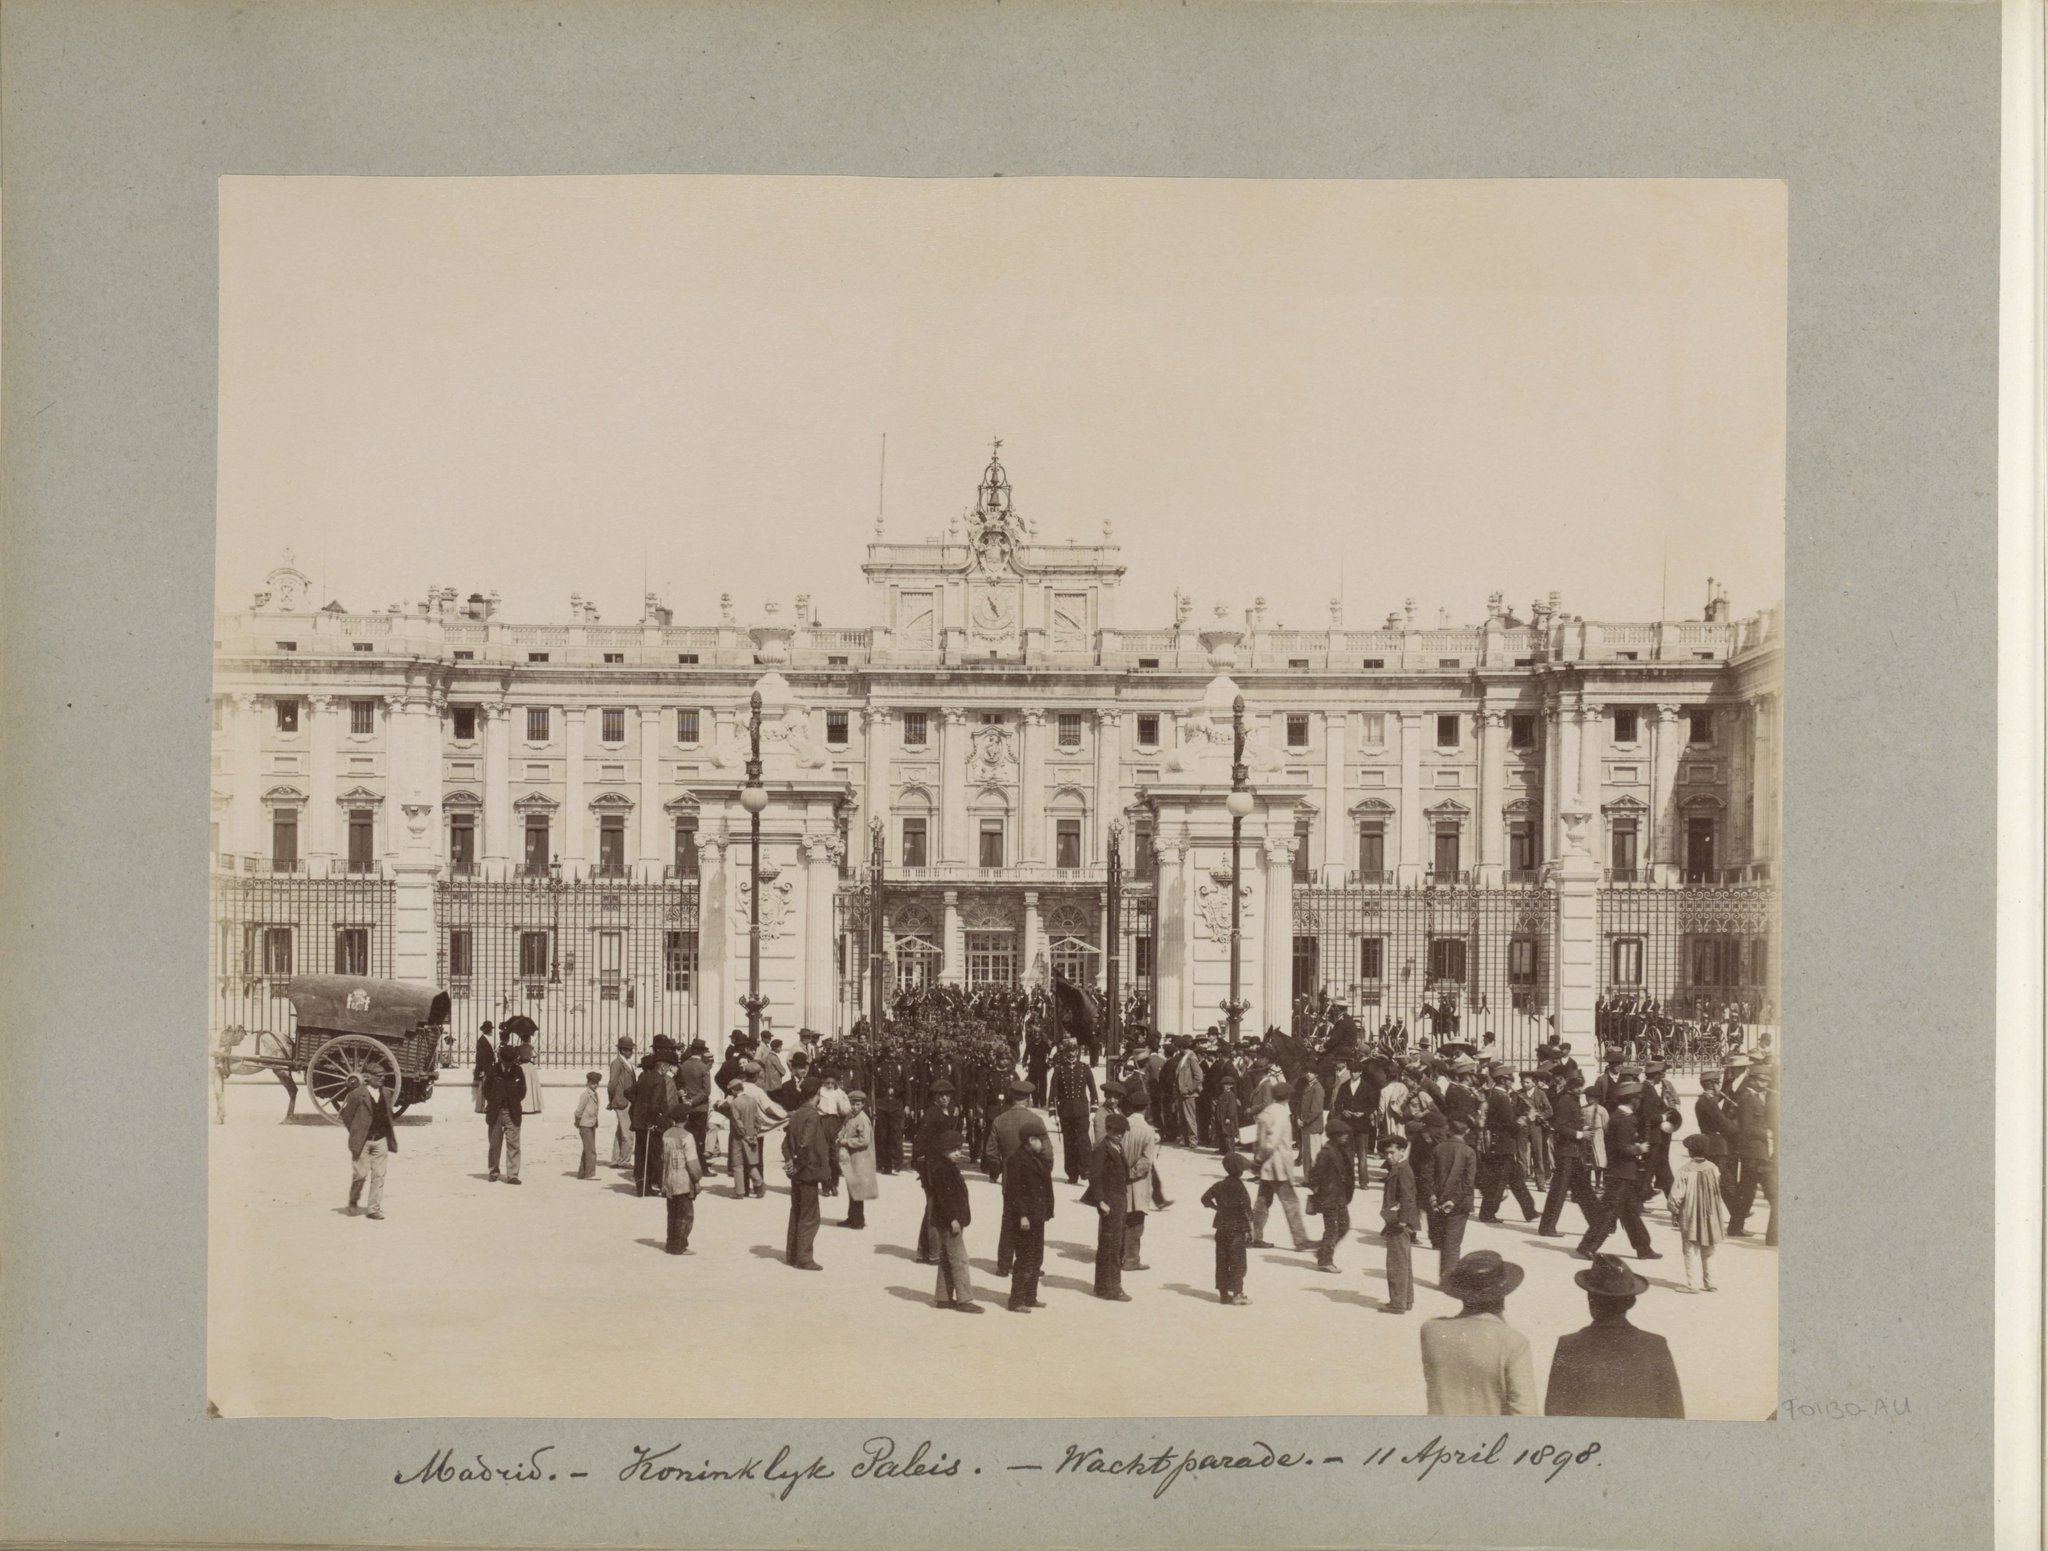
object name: album leaf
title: Publiek bekijkt parade van de paleiswacht bij het Koninklijk Paleis in Madrid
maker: Anonymous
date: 1880-1898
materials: paper, photographic support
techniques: albumen print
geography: royal palace of madrid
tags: guardian, palace, military parade, pageant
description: Onderdeel van Reisalbum met foto's van bezienswaardigheden in Frankrijk, Spanje, Italië, Duitsland, Zwitserland en Oostenrijk.